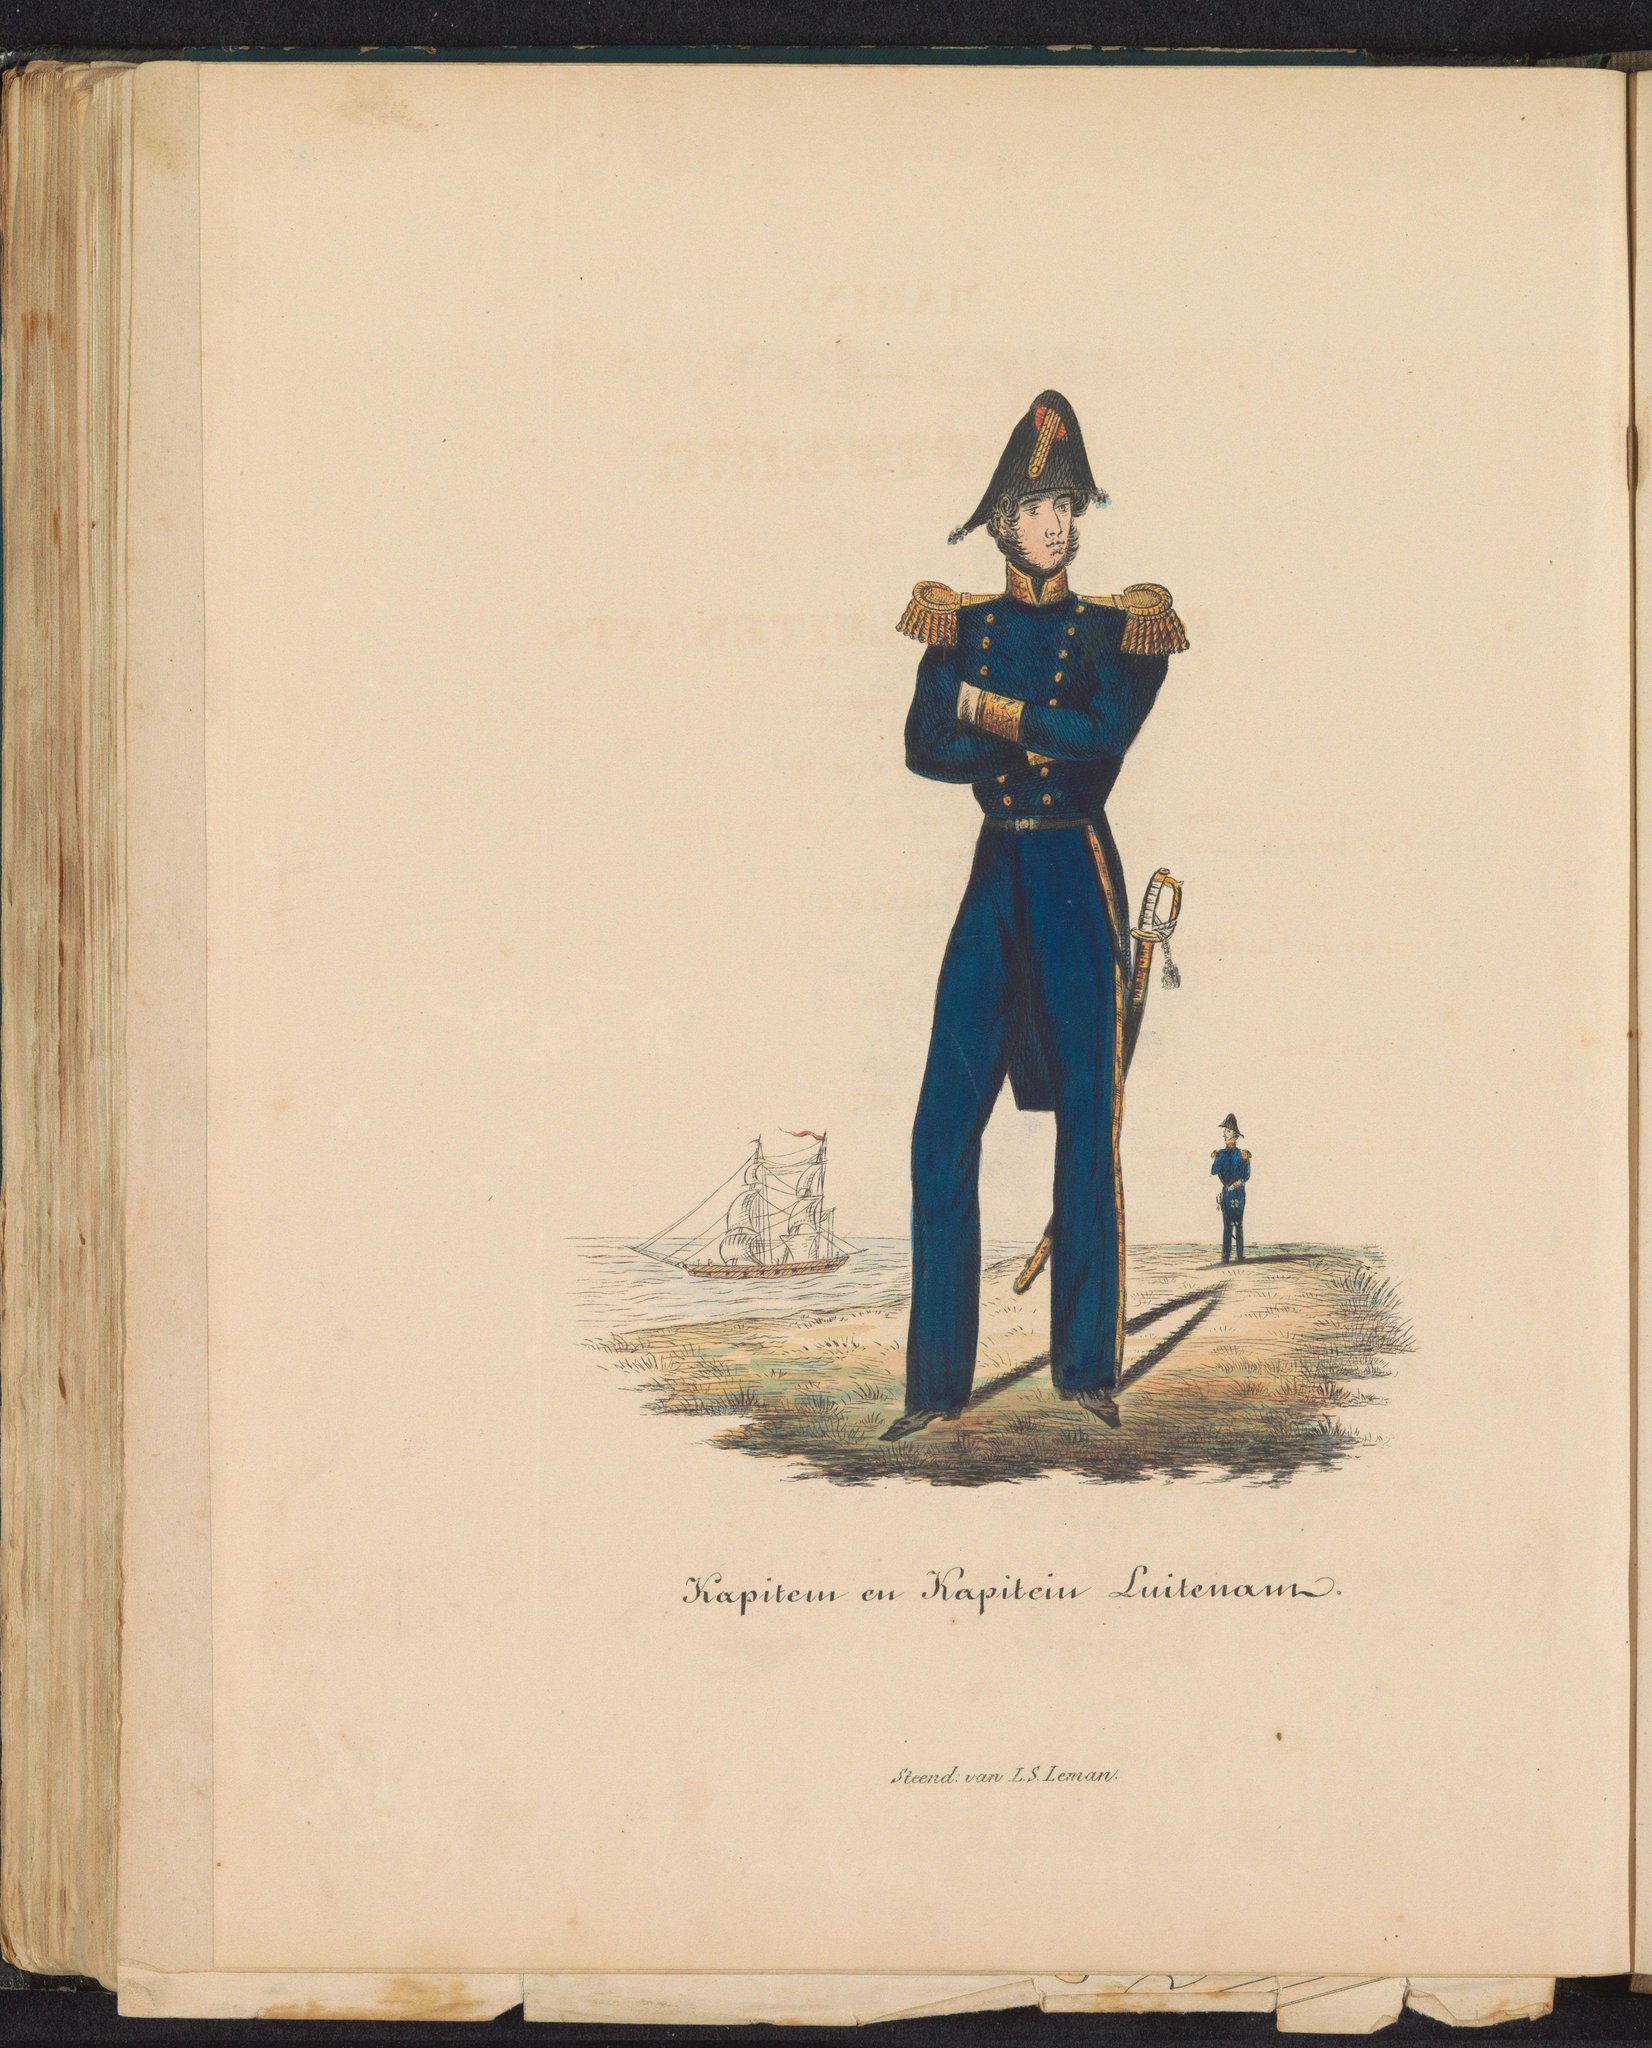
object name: costume print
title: Uniform voor de kapiteins en kapitein-luitenants van de Marine, 1845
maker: louis salomon leman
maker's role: steendrukker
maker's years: 1818-1889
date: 1845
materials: paper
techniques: hand coloring, lithograph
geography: netherlands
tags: (military) uniforms, netherlands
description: Uniform voor de kapiteins en kapitein-luitenants van de Marine. Illustratie in een boek uit 1845 over de uniformen en kledingstukken van de Nederlandse land-, zeemacht en schutterijen in Nederland en in de overzeese gebiedsdelen.